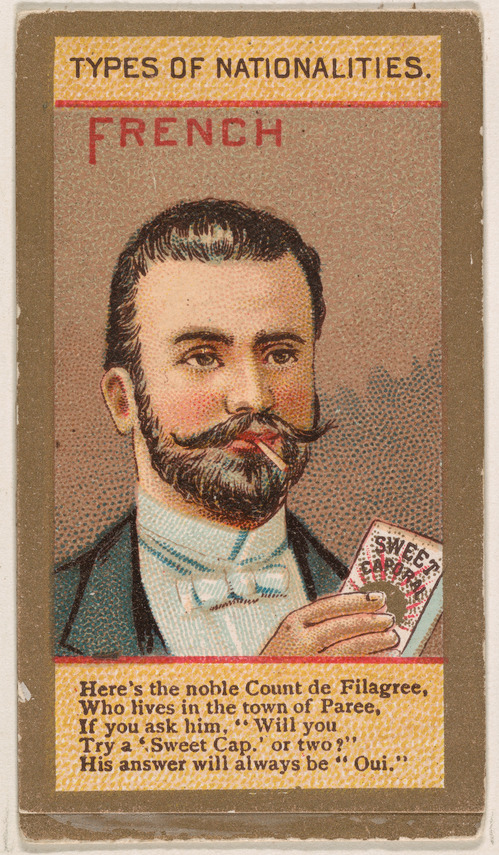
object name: print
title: French, Peasant in Holiday Attire, from Types of Nationalities (N240) issued by Kinney Bros.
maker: kinney brothers tobacco company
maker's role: publisher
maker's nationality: american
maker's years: 1869-2011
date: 1890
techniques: color lithograph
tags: men,smoking